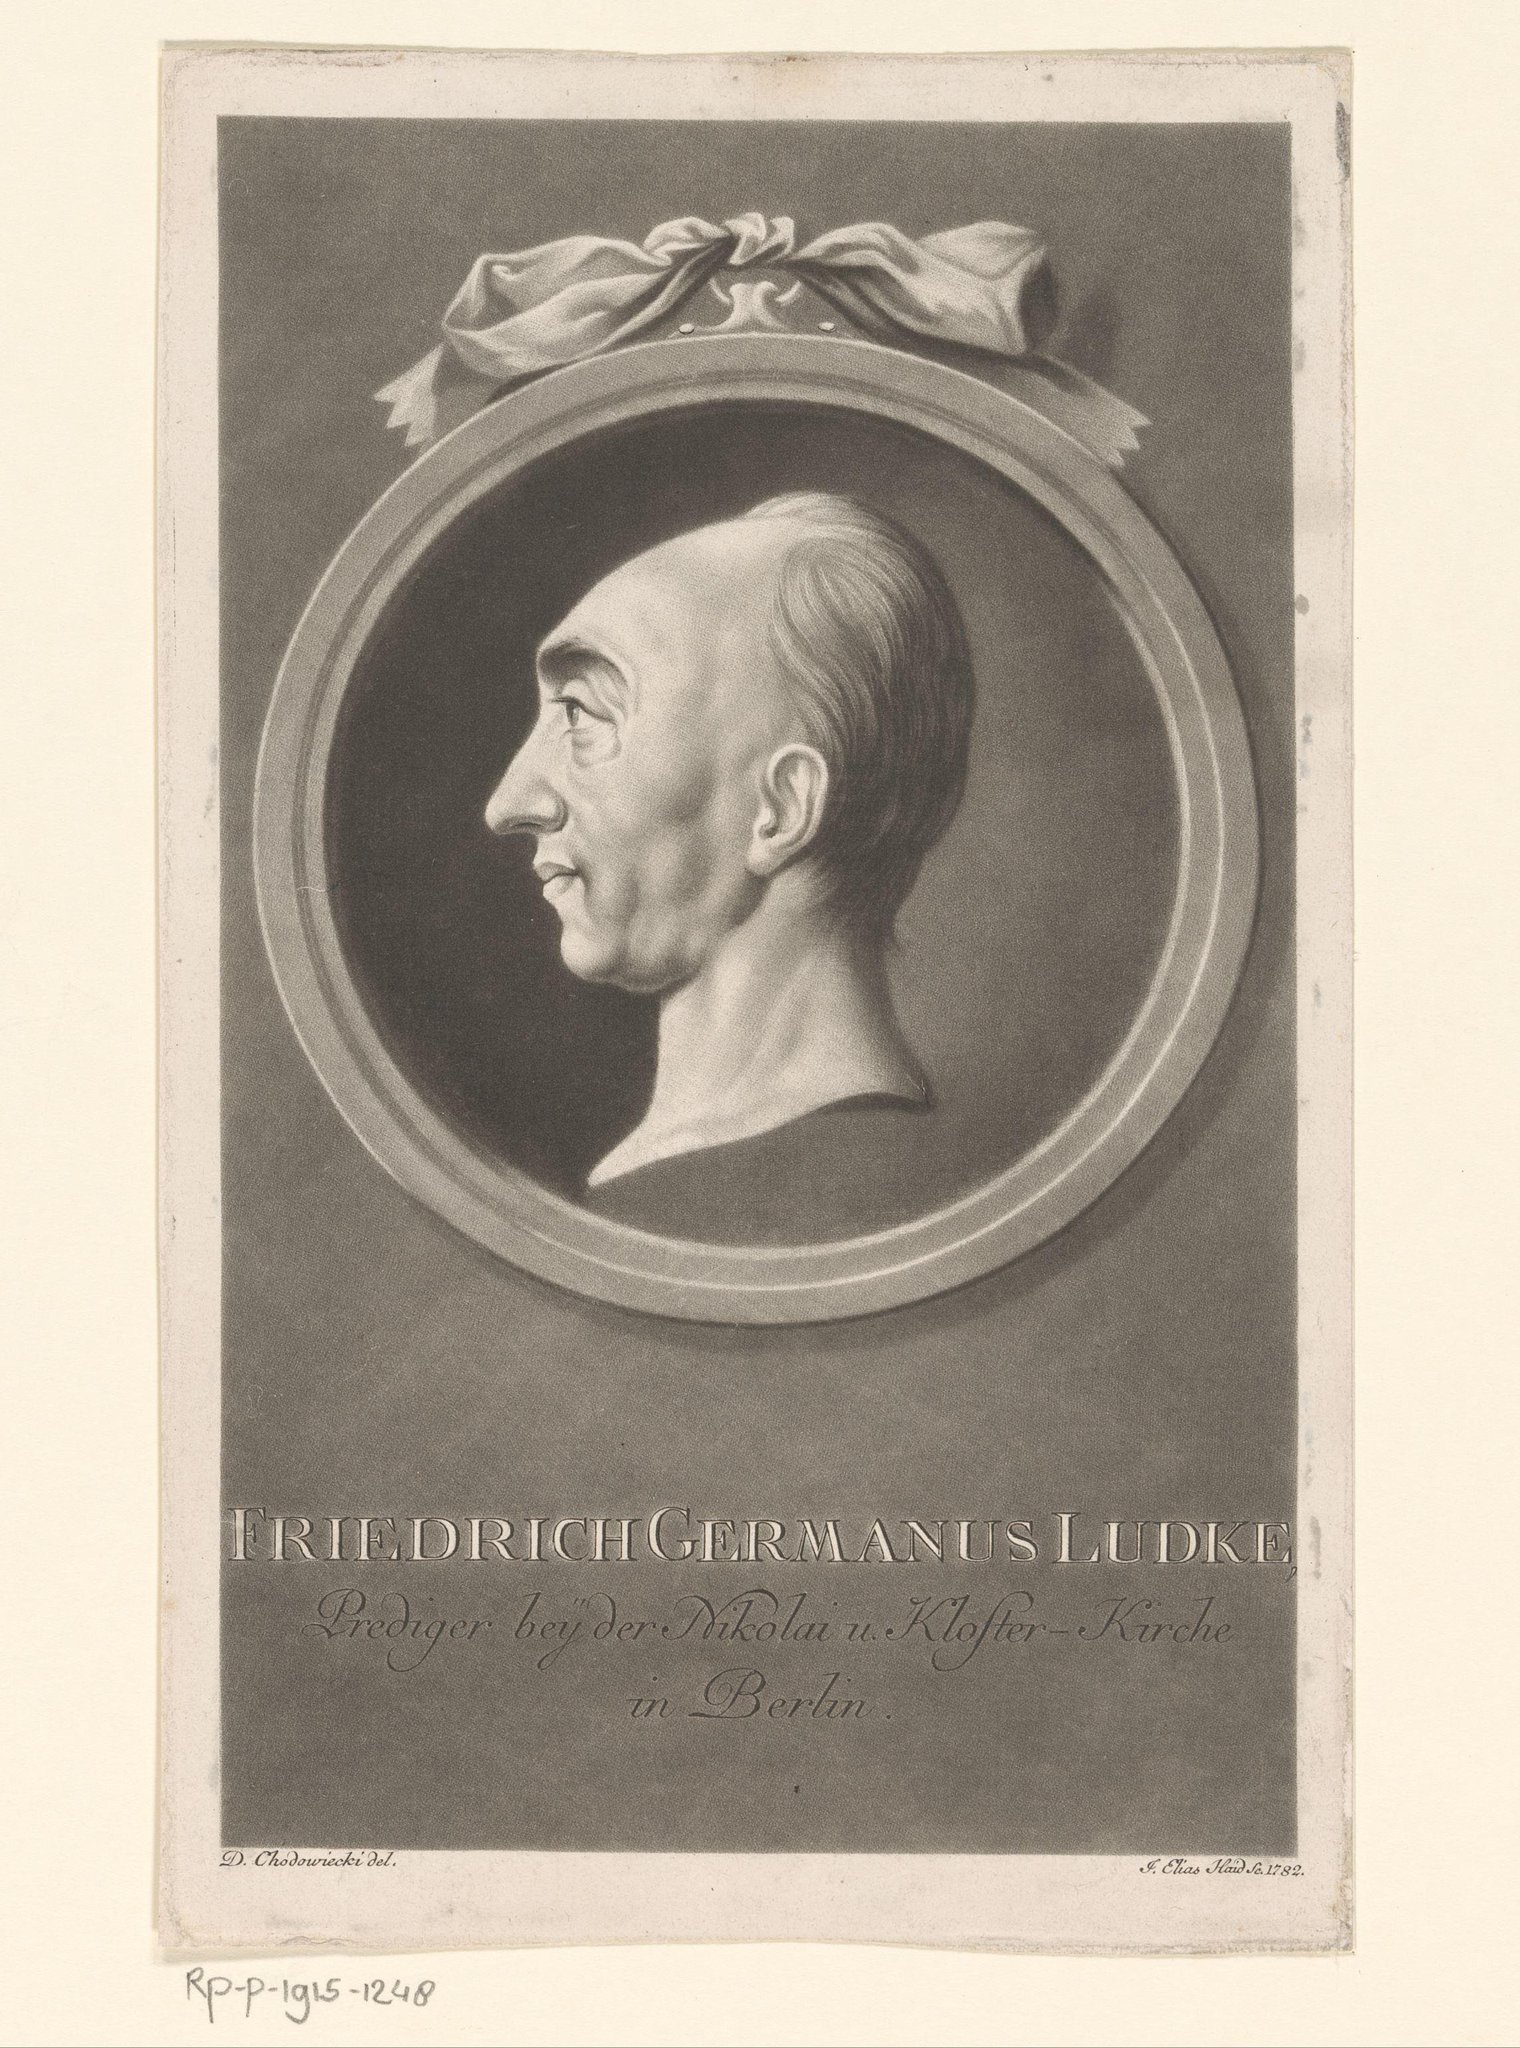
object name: print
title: Portret van Friedrich Germanus Lüdke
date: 1782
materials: paper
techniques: mezzotint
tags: theologian, ornament ~ medallion, historical persons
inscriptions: collector's mark: Lugt 2228